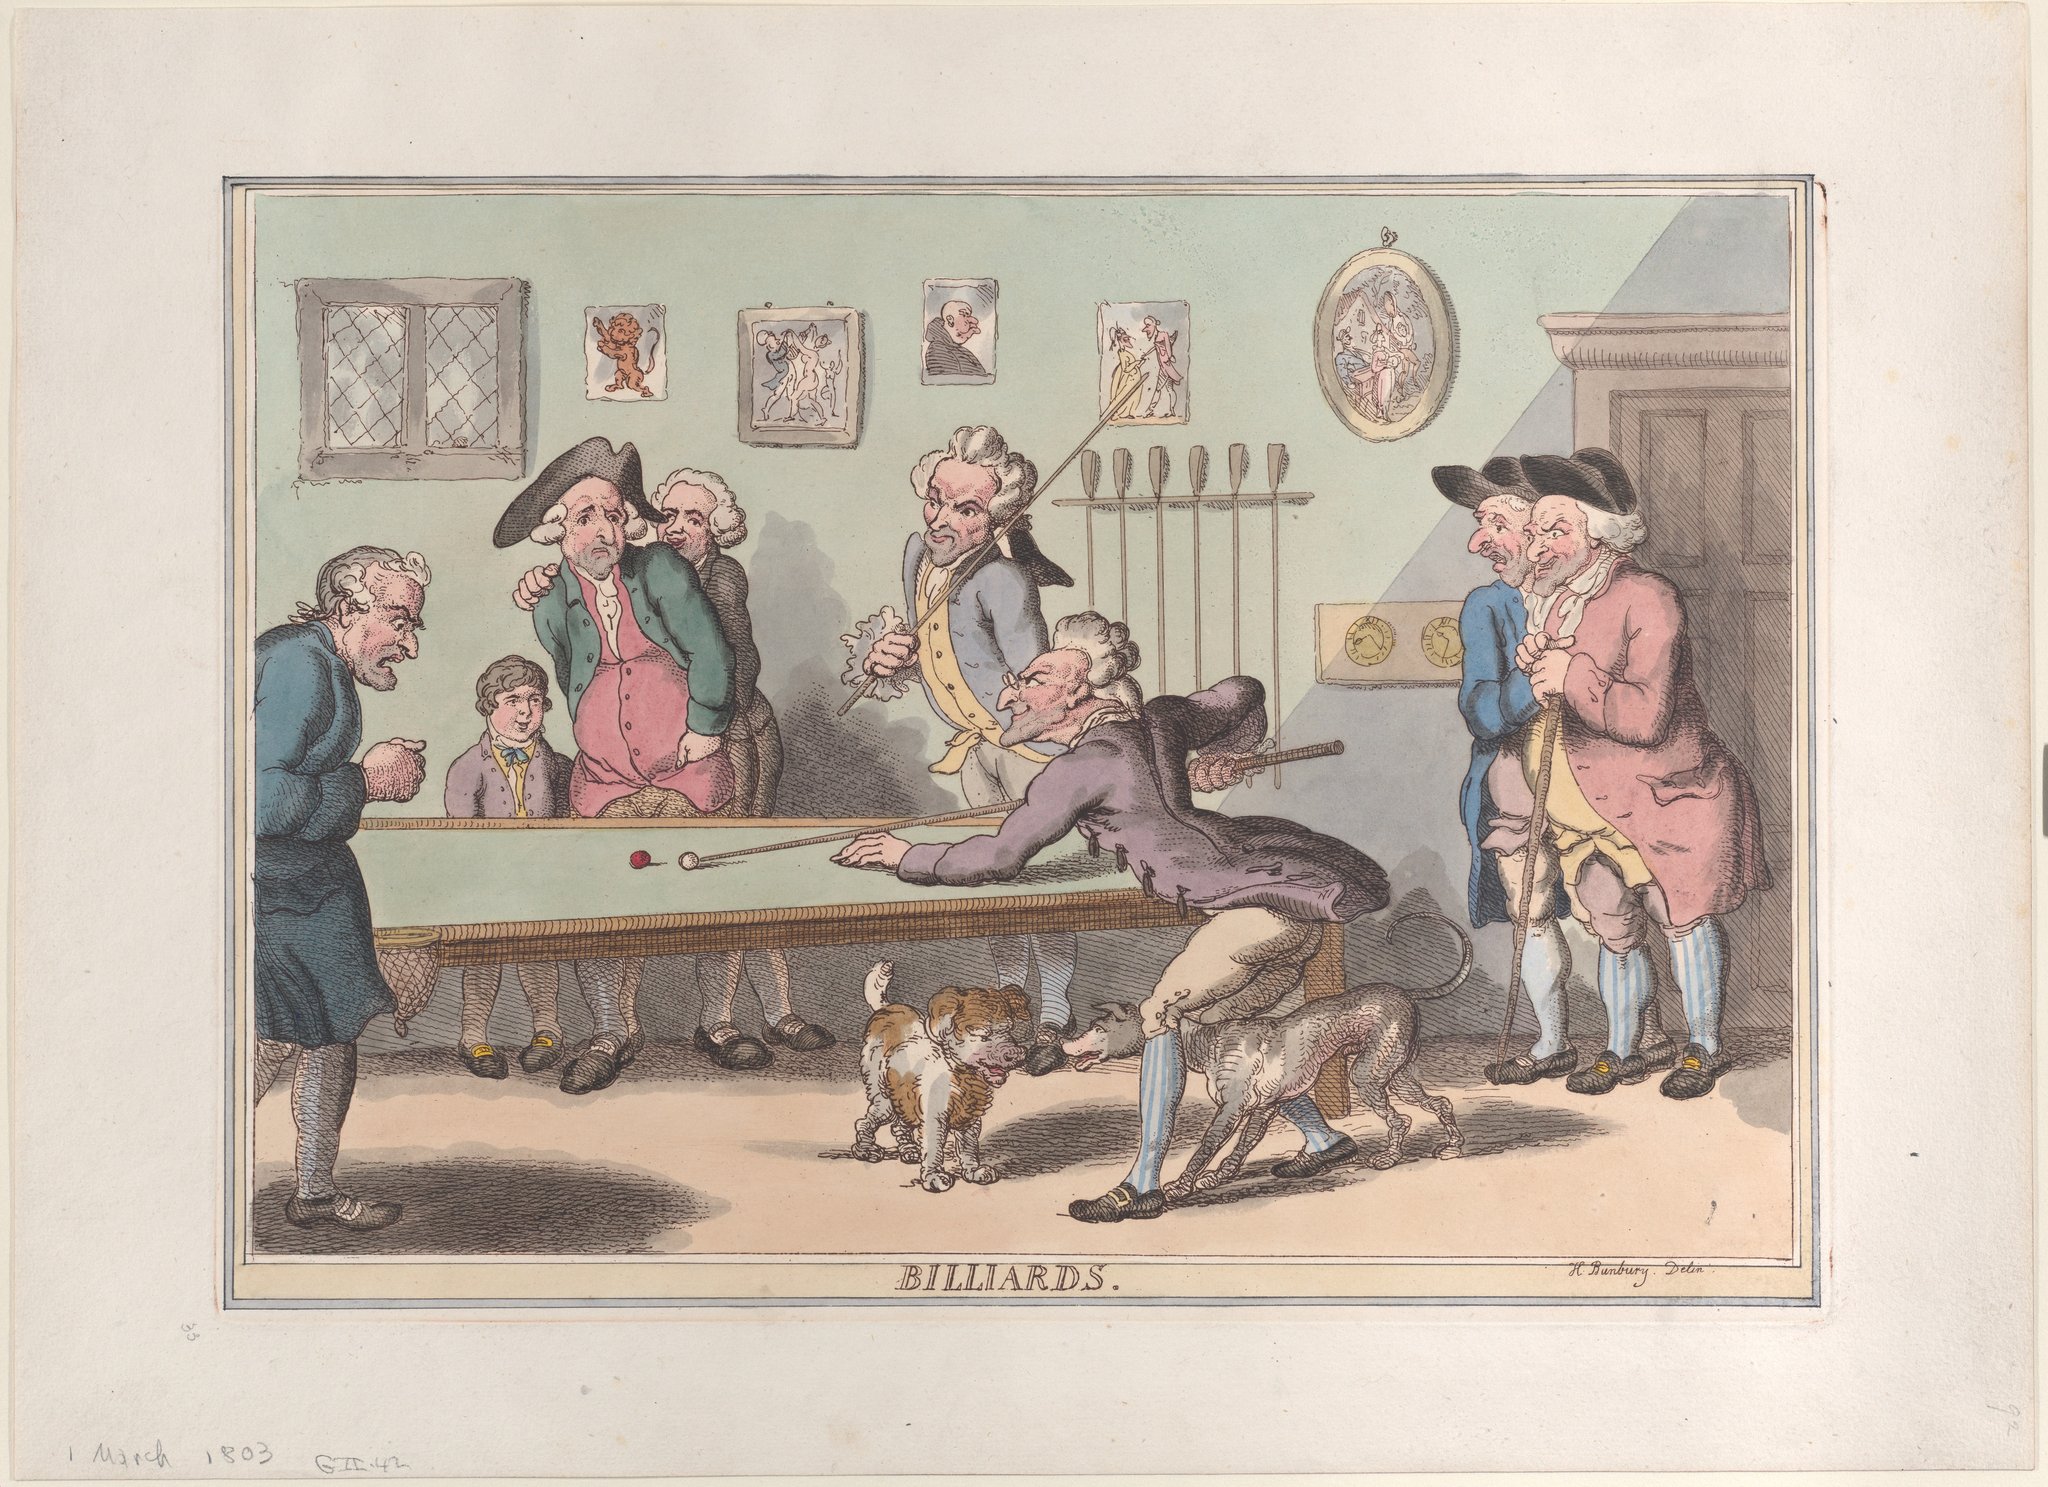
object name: print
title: Billards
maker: thomas rowlandson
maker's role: artist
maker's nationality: british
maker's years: 1757-1827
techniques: etching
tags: satire,men,billiards,dogs